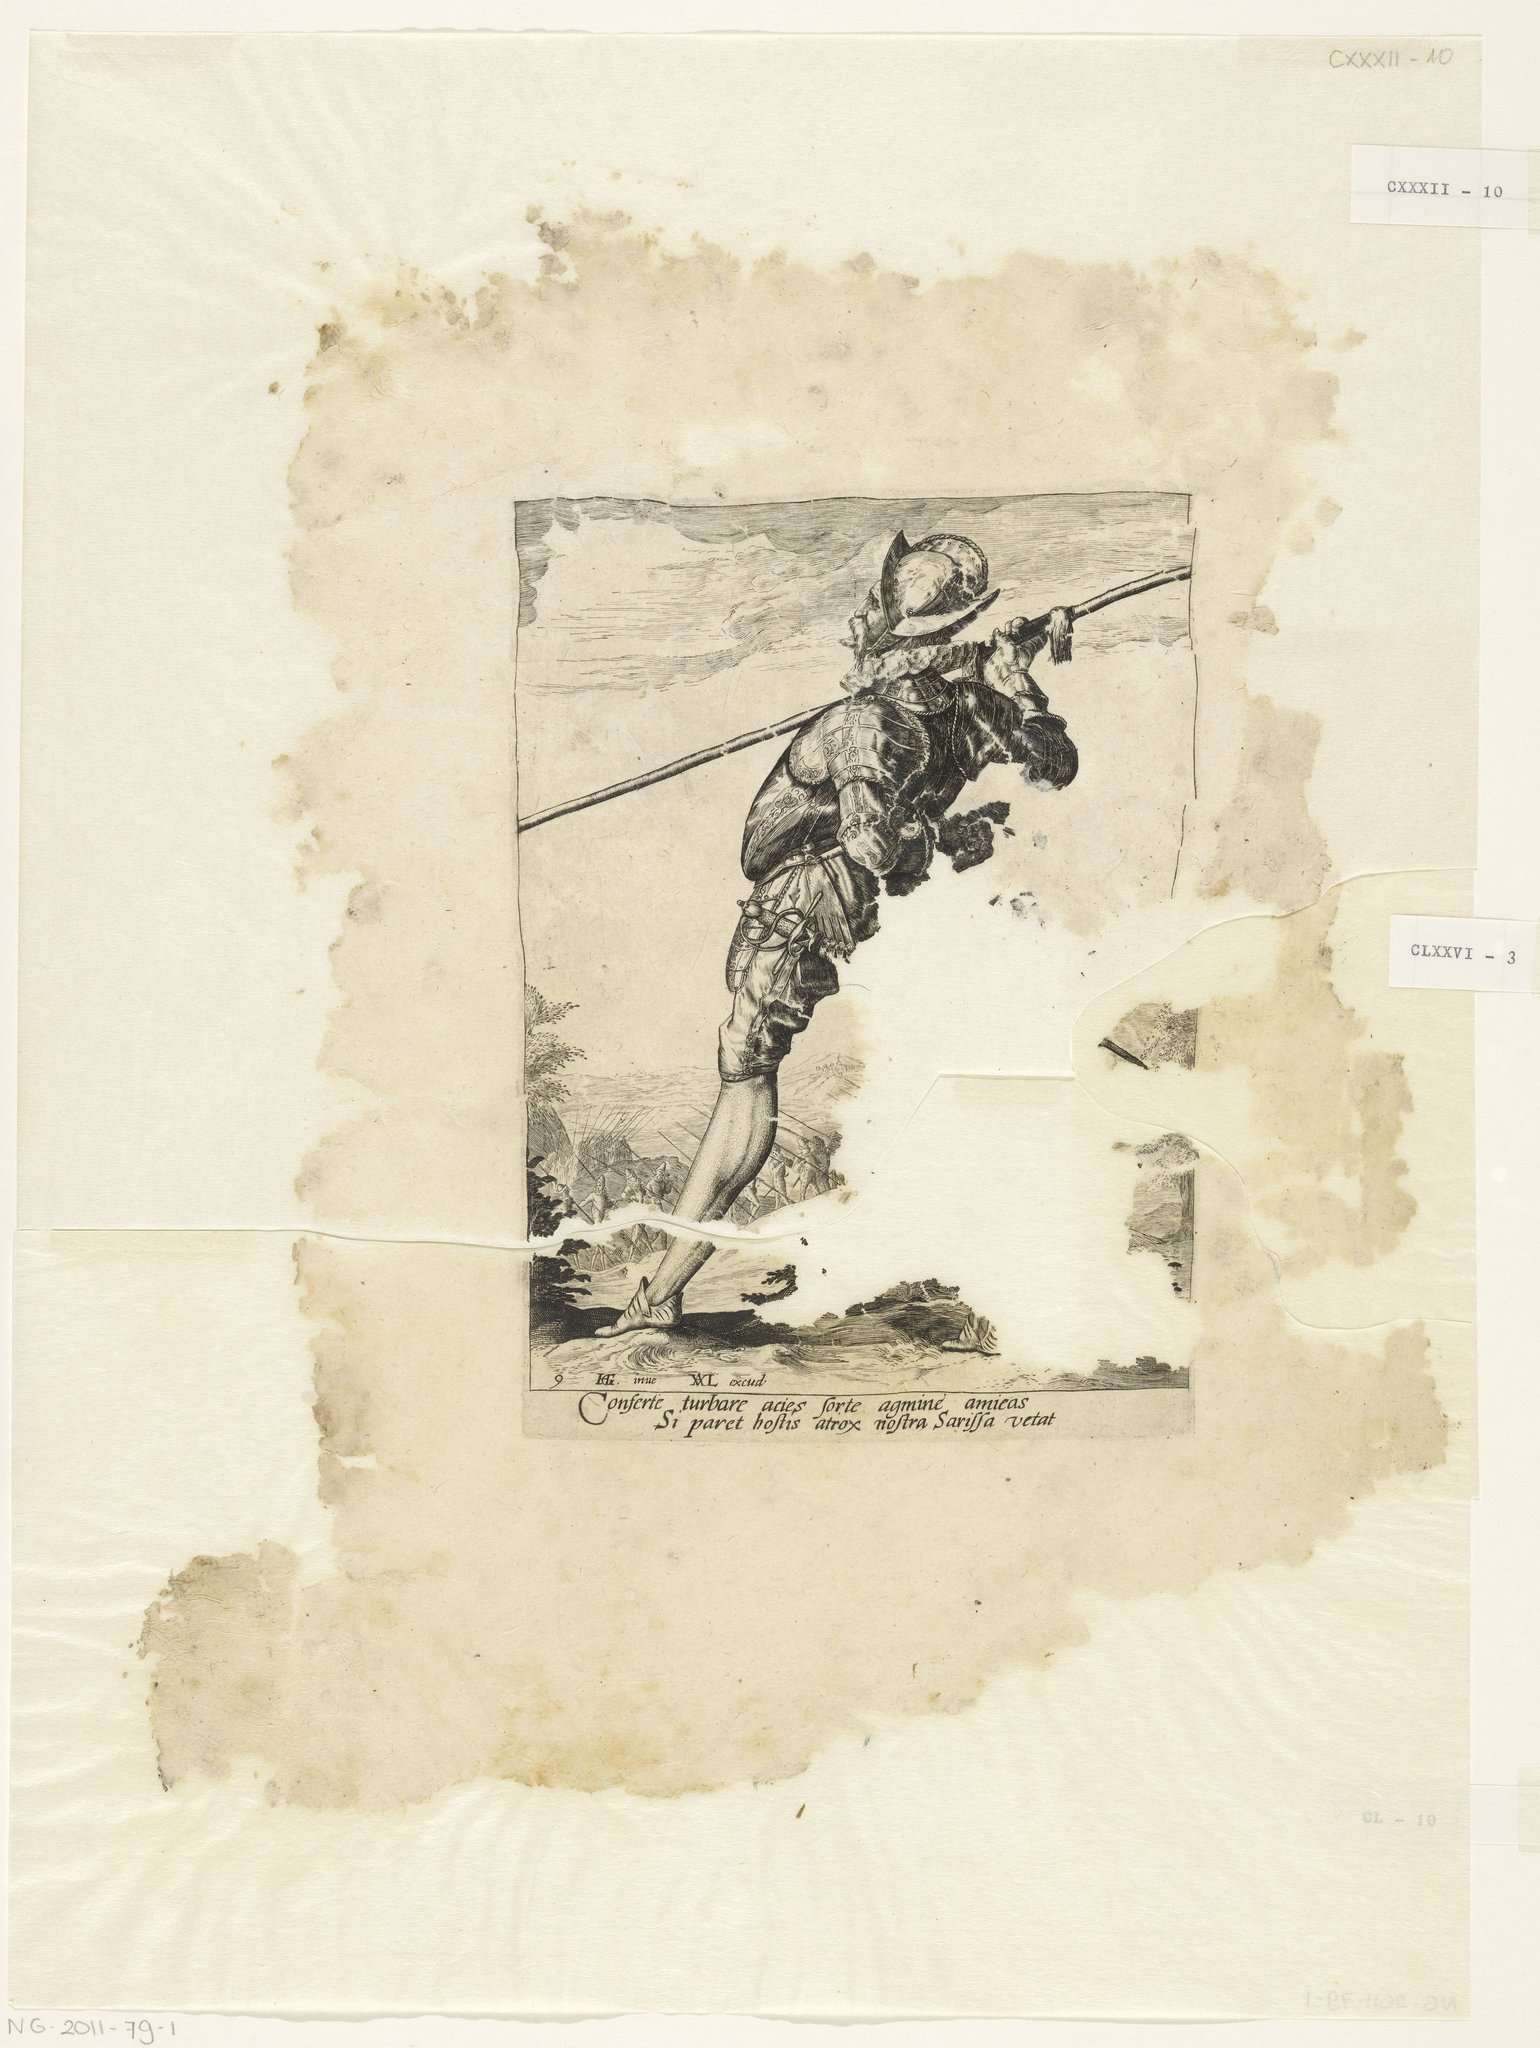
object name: print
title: Piekenier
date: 1587-1596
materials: paper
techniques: engraving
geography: northern netherlands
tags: helved weapons, polearms (for striking, hacking, thrusting): pike, private soldier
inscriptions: watermark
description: De prenten in de Nova Zembla collectie zijn tijdens een expeditie van Willem Barendsz en Jacob van Heemskerk in 1596-1597 noodgedwongen in het winterkamp, het ‘Behouden Huis’, op het eiland achtergelaten. De prenten waren in één of meerdere stapels als handelswaar meegenomen vanuit Amsterdam. Bijna drie eeuwen later, in 1871, keerde de Noor Elling Carlsen terug naar Nova Zembla en vond daar de restanten van het ‘Behouden Huis, inclusief een groot deel van de inventaris. Een deel van de prenten, in de vorm van aaneengekoekte kluiten, werd toen ook teruggevonden. De papierkluiten waren soms op meerdere plekken gebroken. Tussen 1975-1979 zijn de prenten van elkaar gescheiden. Dit leverde in totaal ca. 1000 fragmenten van ca. 400 afdrukken van ca. 150 verschillende prenten op. Voor zover mogelijk zijn de fragmenten samengevoegd en zijn de prenten gereconstrueerd.